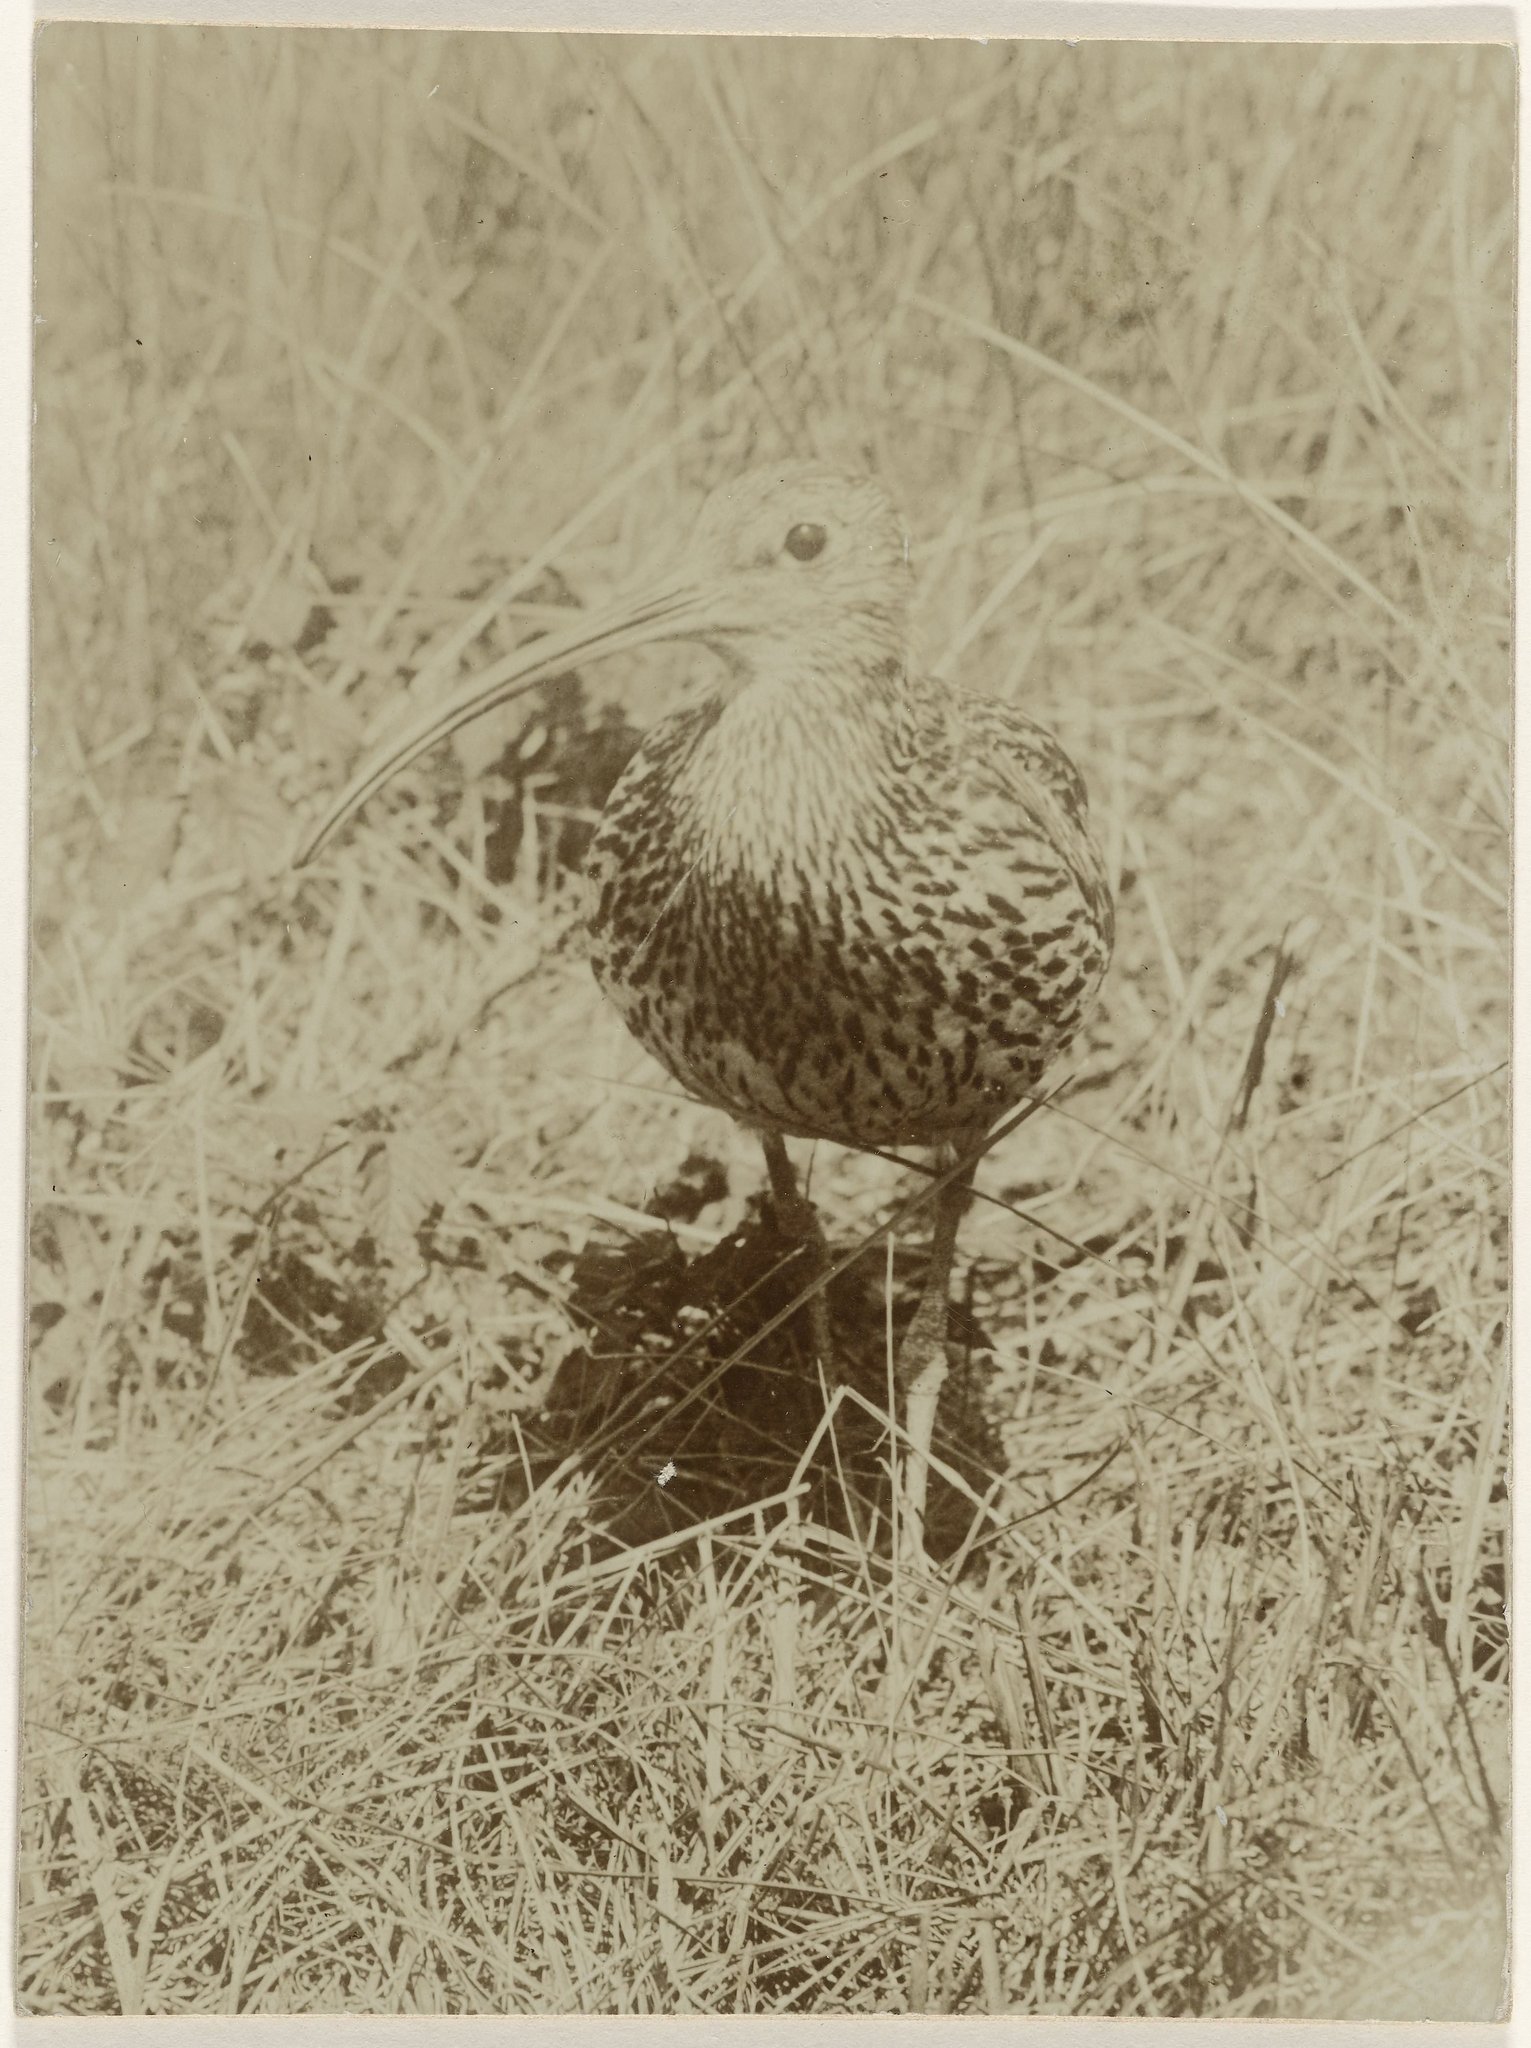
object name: photograph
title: Wulp in duingras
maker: richard tepe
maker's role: fotograaf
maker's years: 1864-1952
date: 1900-1940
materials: cardboard, photographic support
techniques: gelatin silver print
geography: netherlands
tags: shore-birds and wading-birds: curlew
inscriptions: : ‘...meniusarcuatus / Grosser / Brachvogel / oder Kranschnepfe / sich seinem Neste / näherend’, signature: ‘foto / R. Tepe’